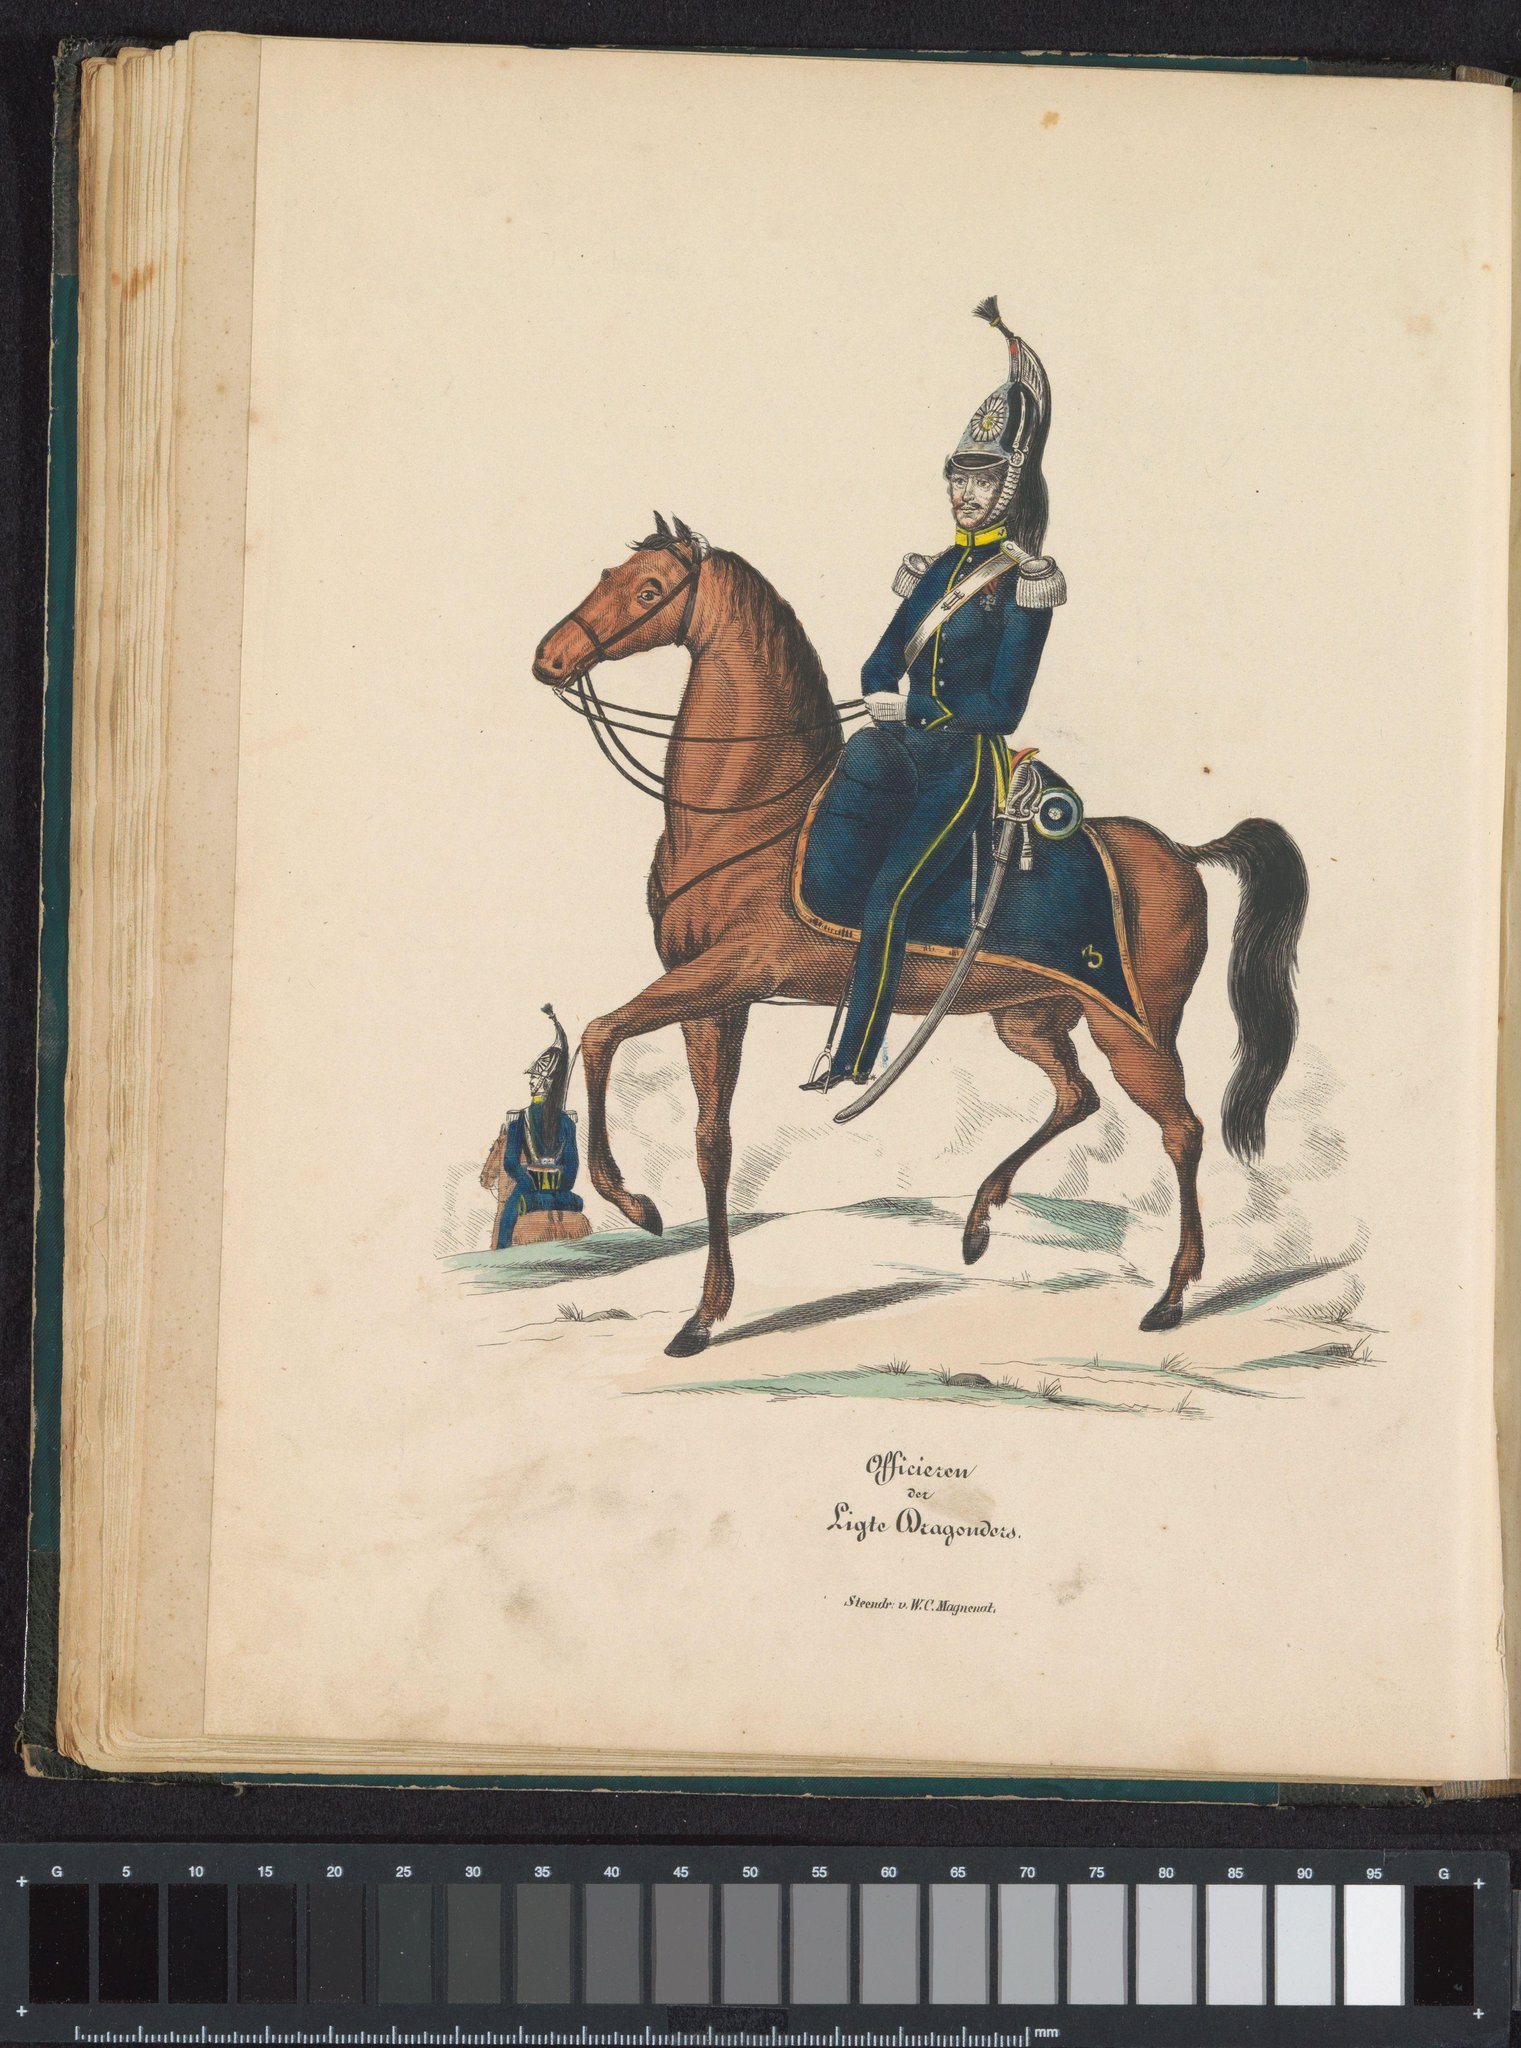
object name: print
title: Uniform van de officieren van de lichte dragonders, 1845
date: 1845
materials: paper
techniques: hand coloring, lithograph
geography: amsterdam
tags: (military) uniforms, netherlands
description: Uniform van de officieren van de lichte dragonders. Illustratie in een boek uit 1845 over de uniformen en kledingstukken van de Nederlandse land-, zeemacht en schutterijen in Nederland en in de overzeese gebiedsdelen.